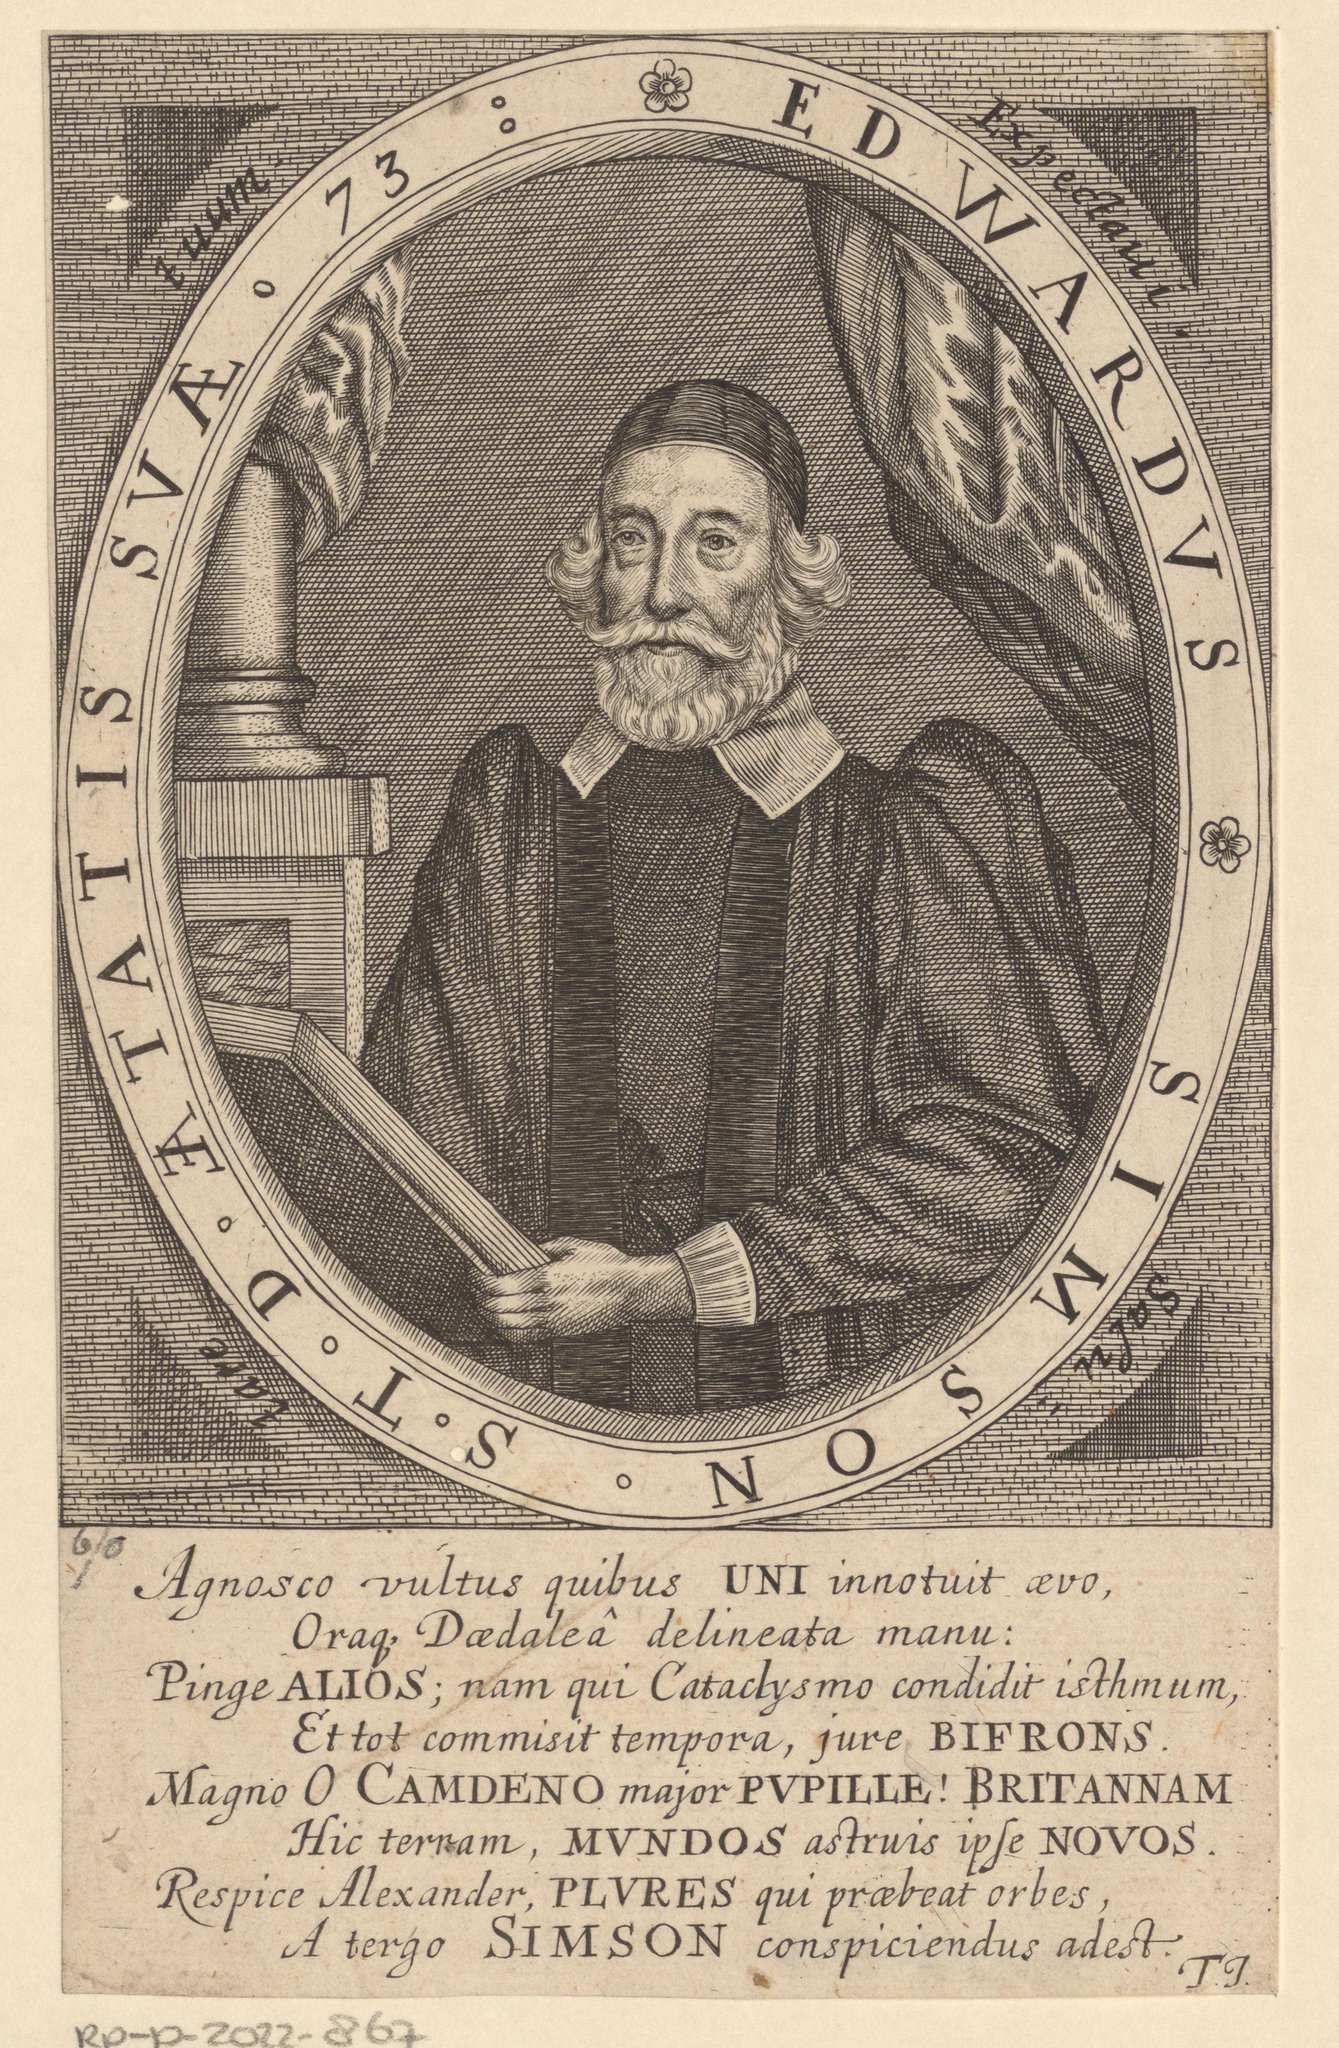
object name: print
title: Portret van Edward Simson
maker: Anonymous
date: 1652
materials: paper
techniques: engraving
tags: historical persons, portrait of a writer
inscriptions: collector's mark: Lugt 2228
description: Met achtregelig onderschrift in het Latijn en tekst in het Latijn rondom het portret.